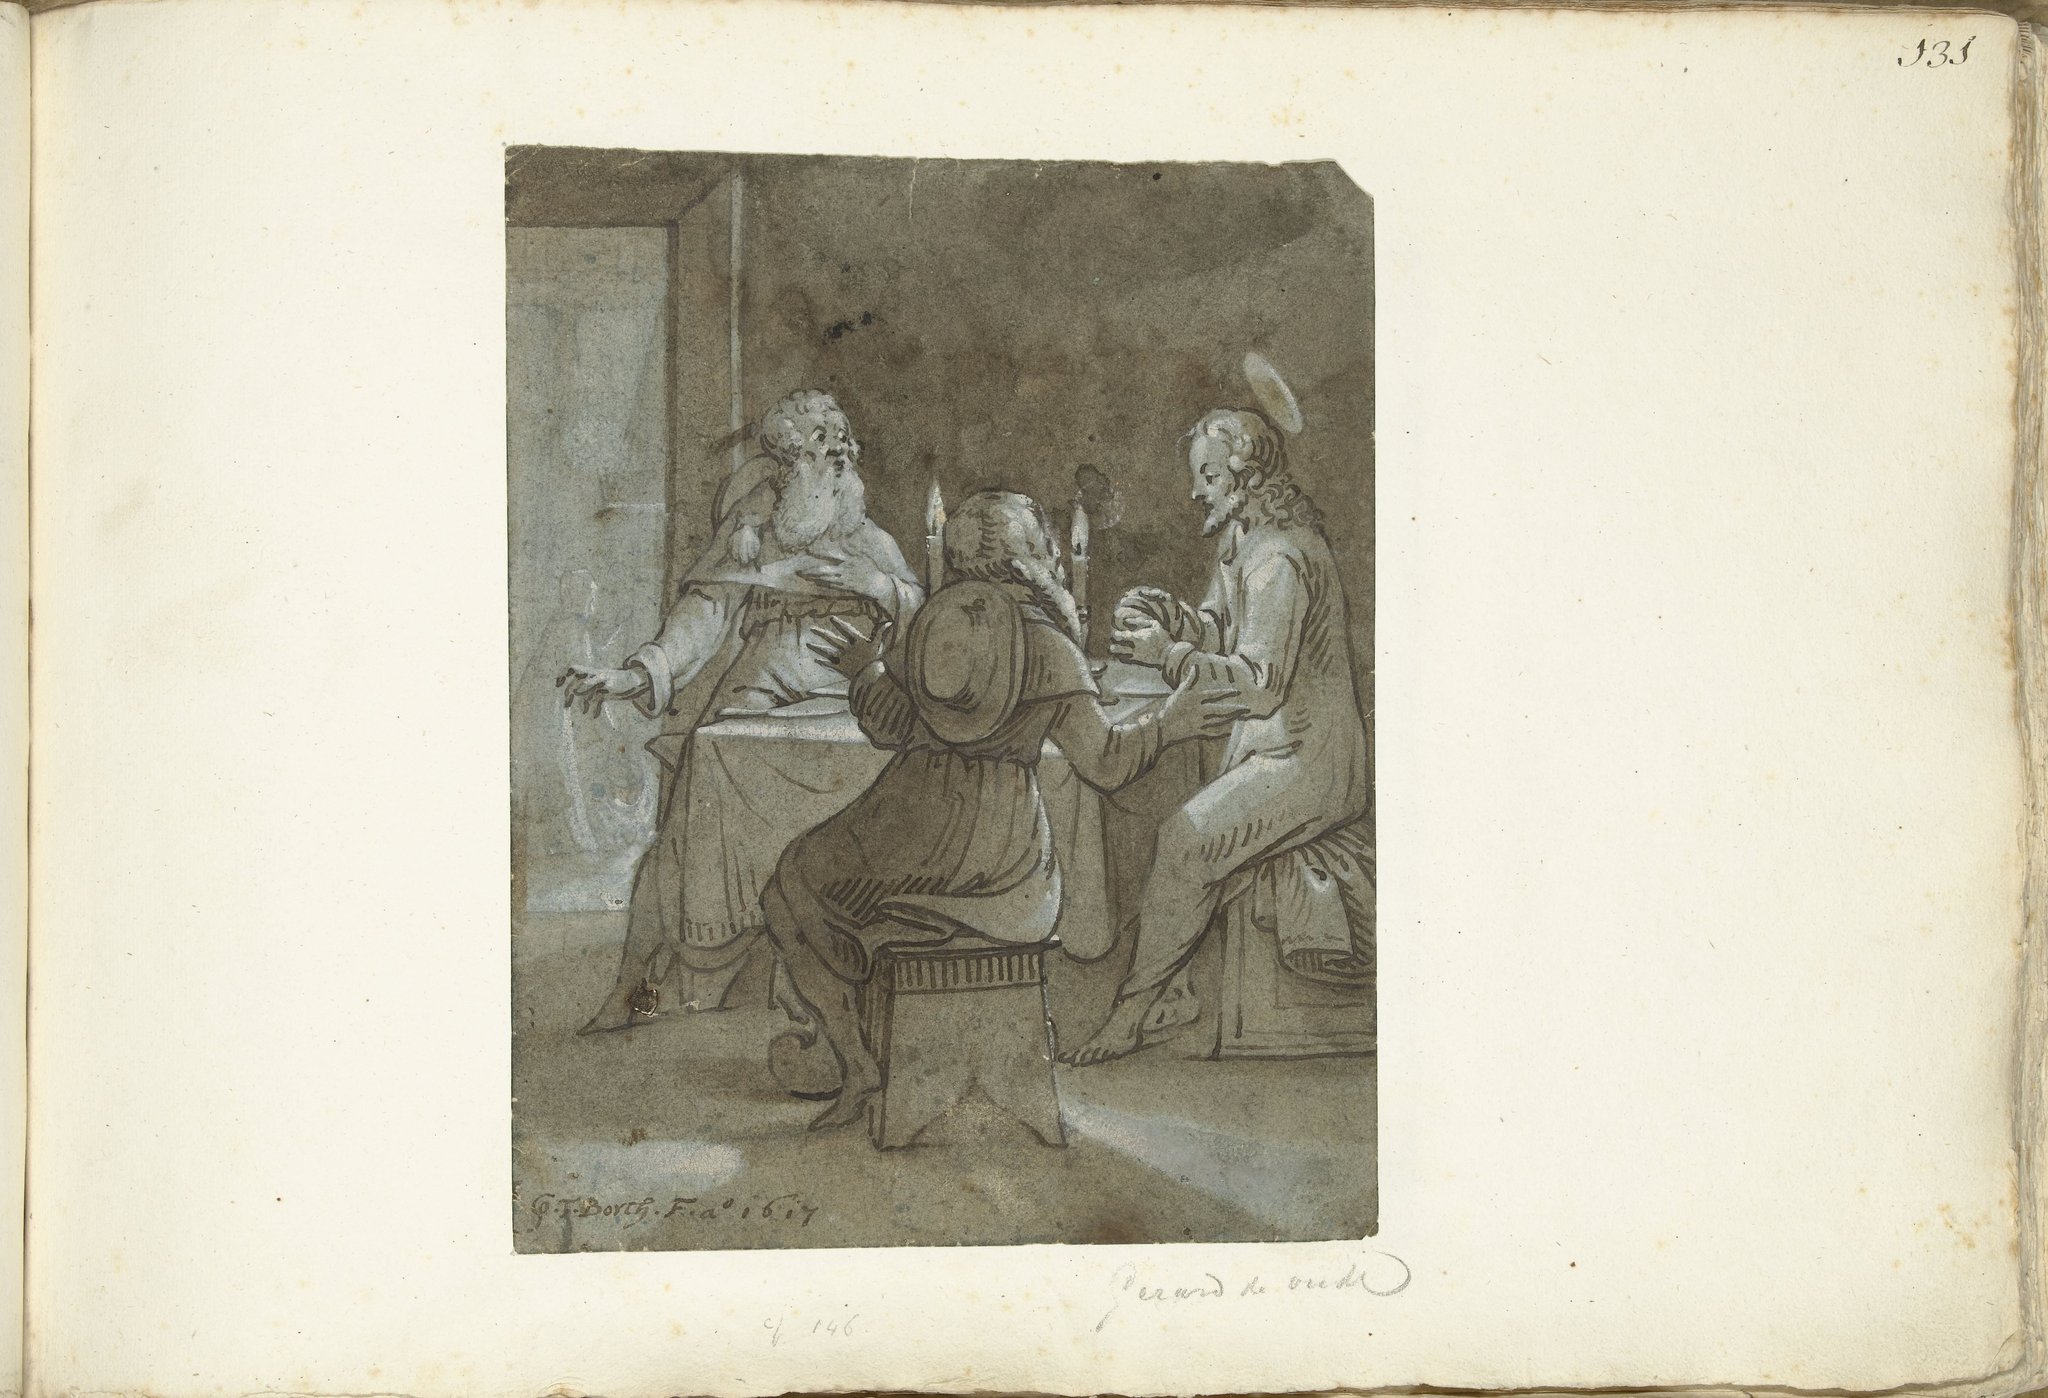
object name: drawing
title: Maaltijd te Emmaüs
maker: gerard ter borch (i)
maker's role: draughtsman, print maker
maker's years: 1584-1662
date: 1617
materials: ink, paper, pencil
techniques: brush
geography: zwolle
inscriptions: annotation: ‘Gerard de Oude’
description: Tekening opgeplakt in het Familie-plakboek.